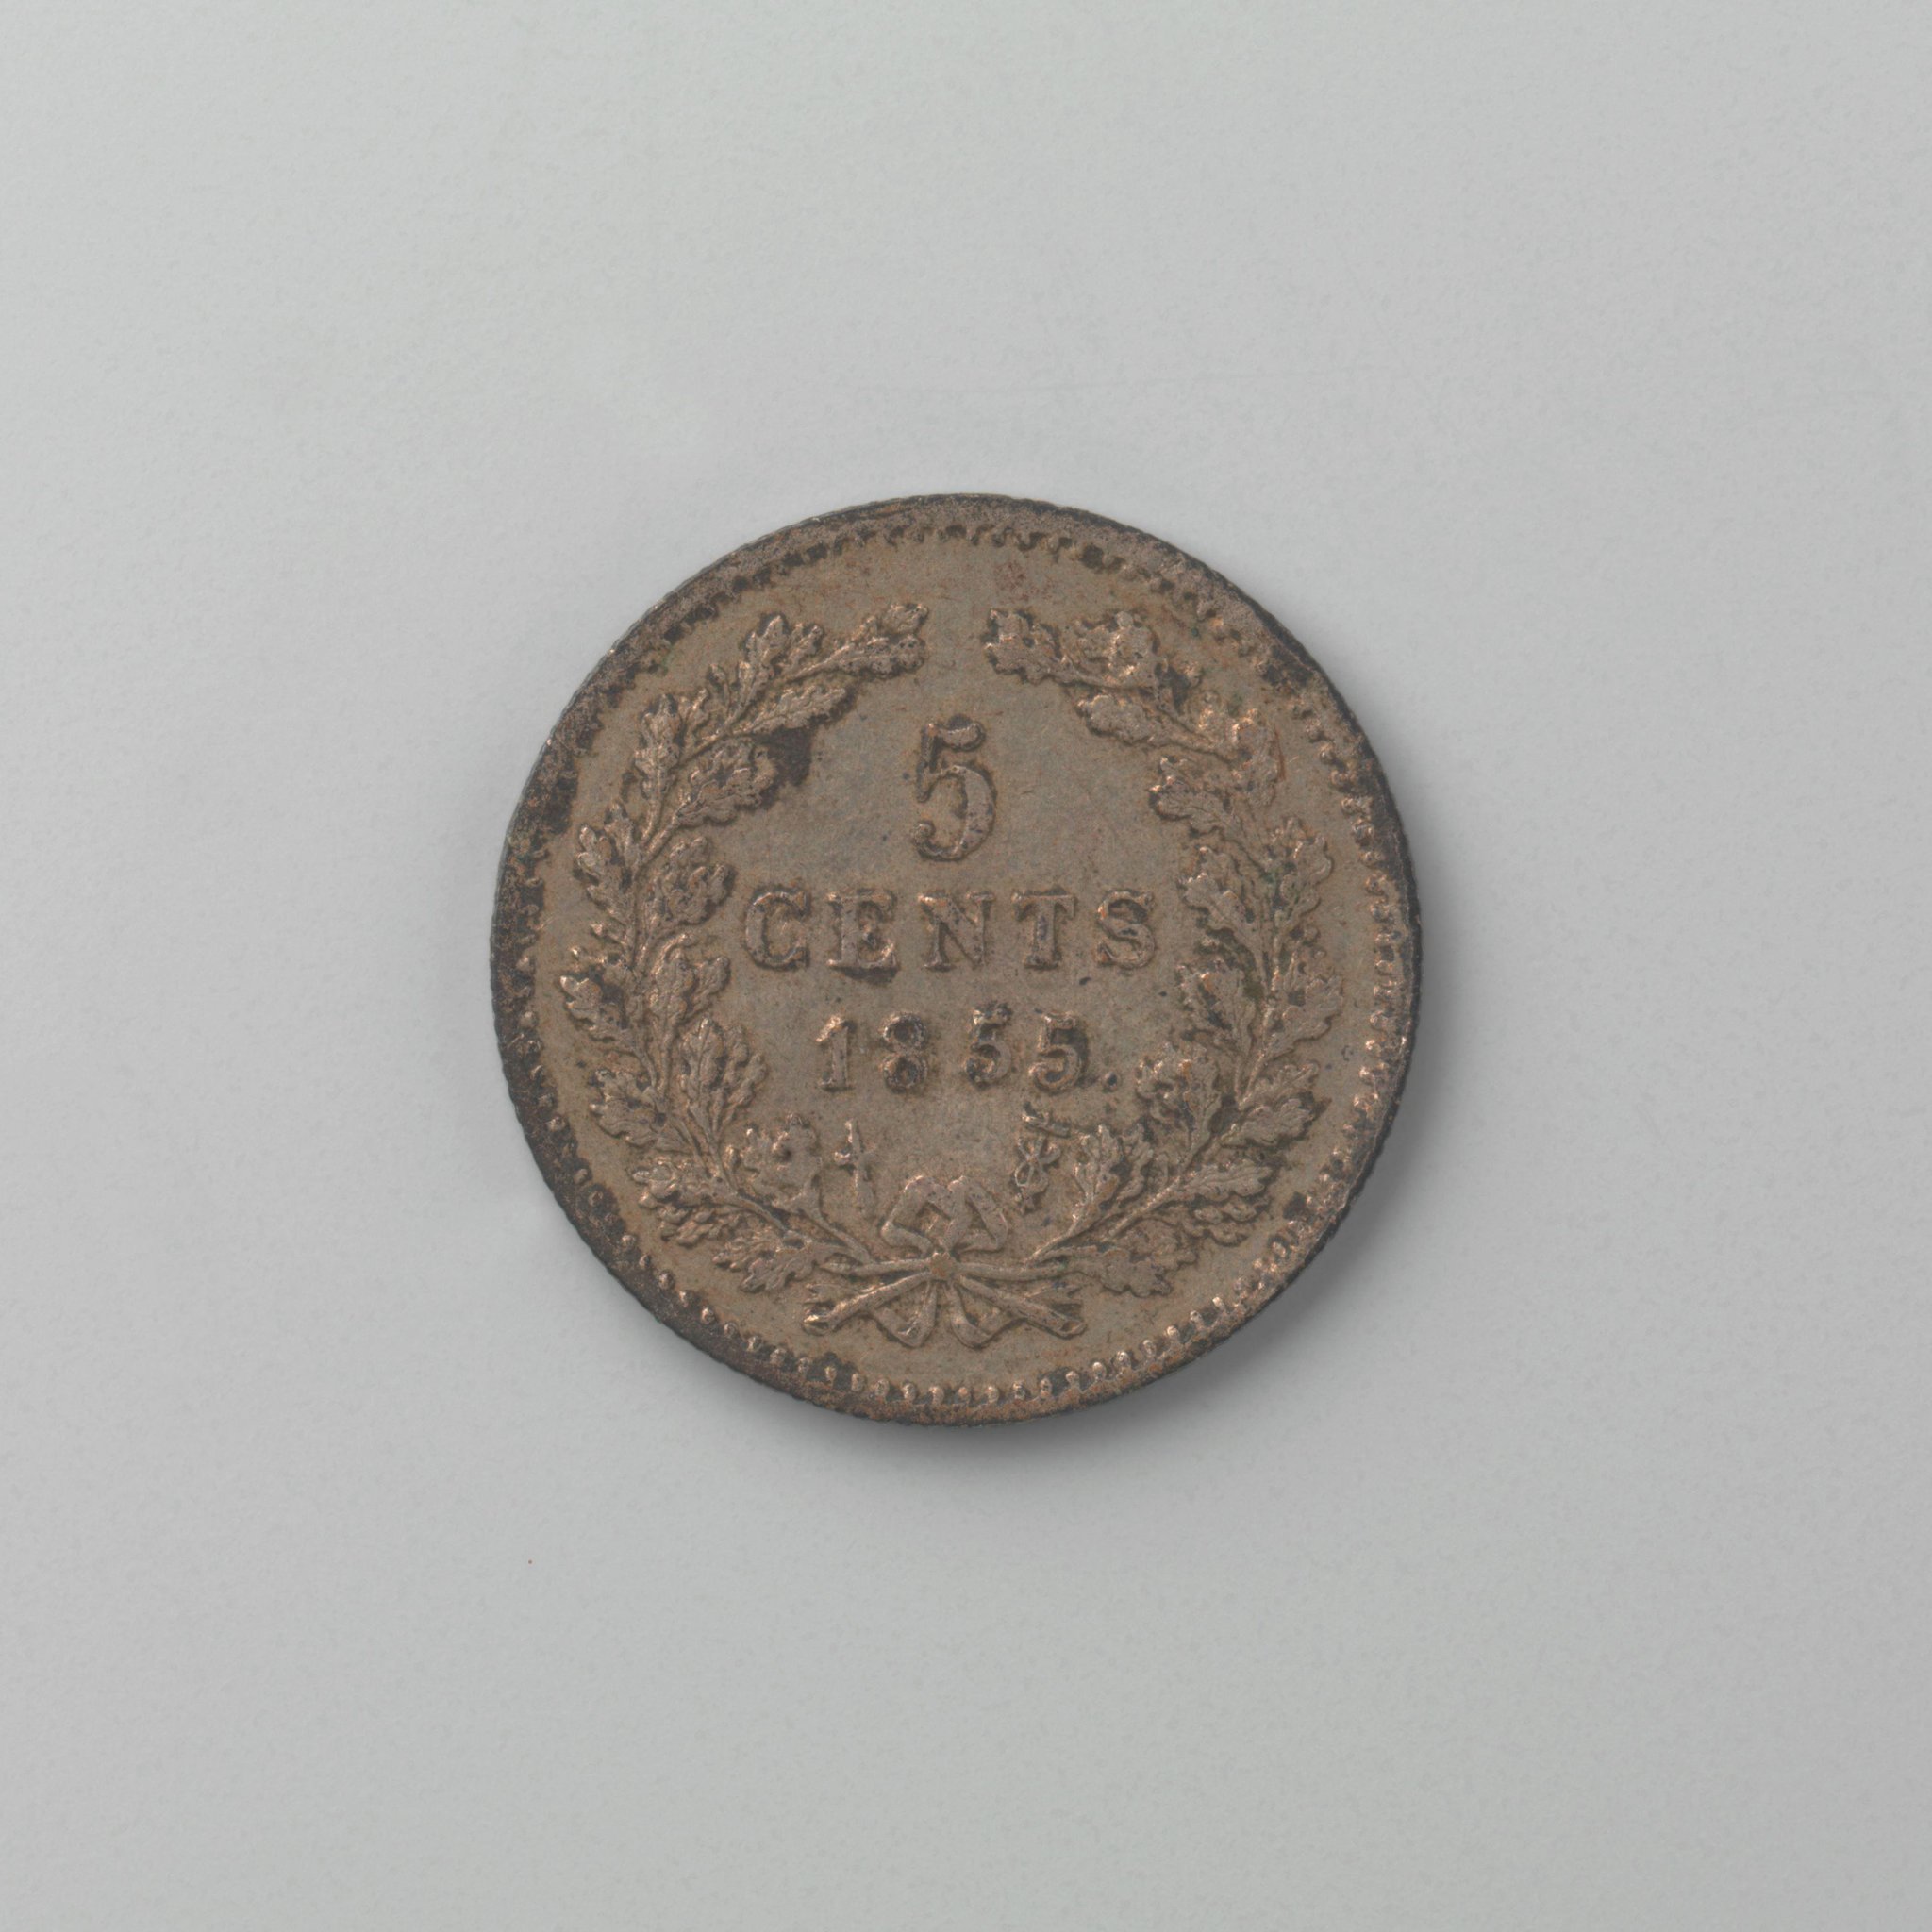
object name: coin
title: Nederland, 5 cent, 1855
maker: willem iii (koning der nederlanden)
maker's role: koning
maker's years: 1817-1890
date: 1855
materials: silver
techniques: striking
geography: utrecht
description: Zilveren munt. Voorzijde: borstbeeld naar rechts. Keerzijde: binnen twee samengebonden eikentakken waarde-aanduiding 5 cents. Daaronder jaartal. Kartelrand.